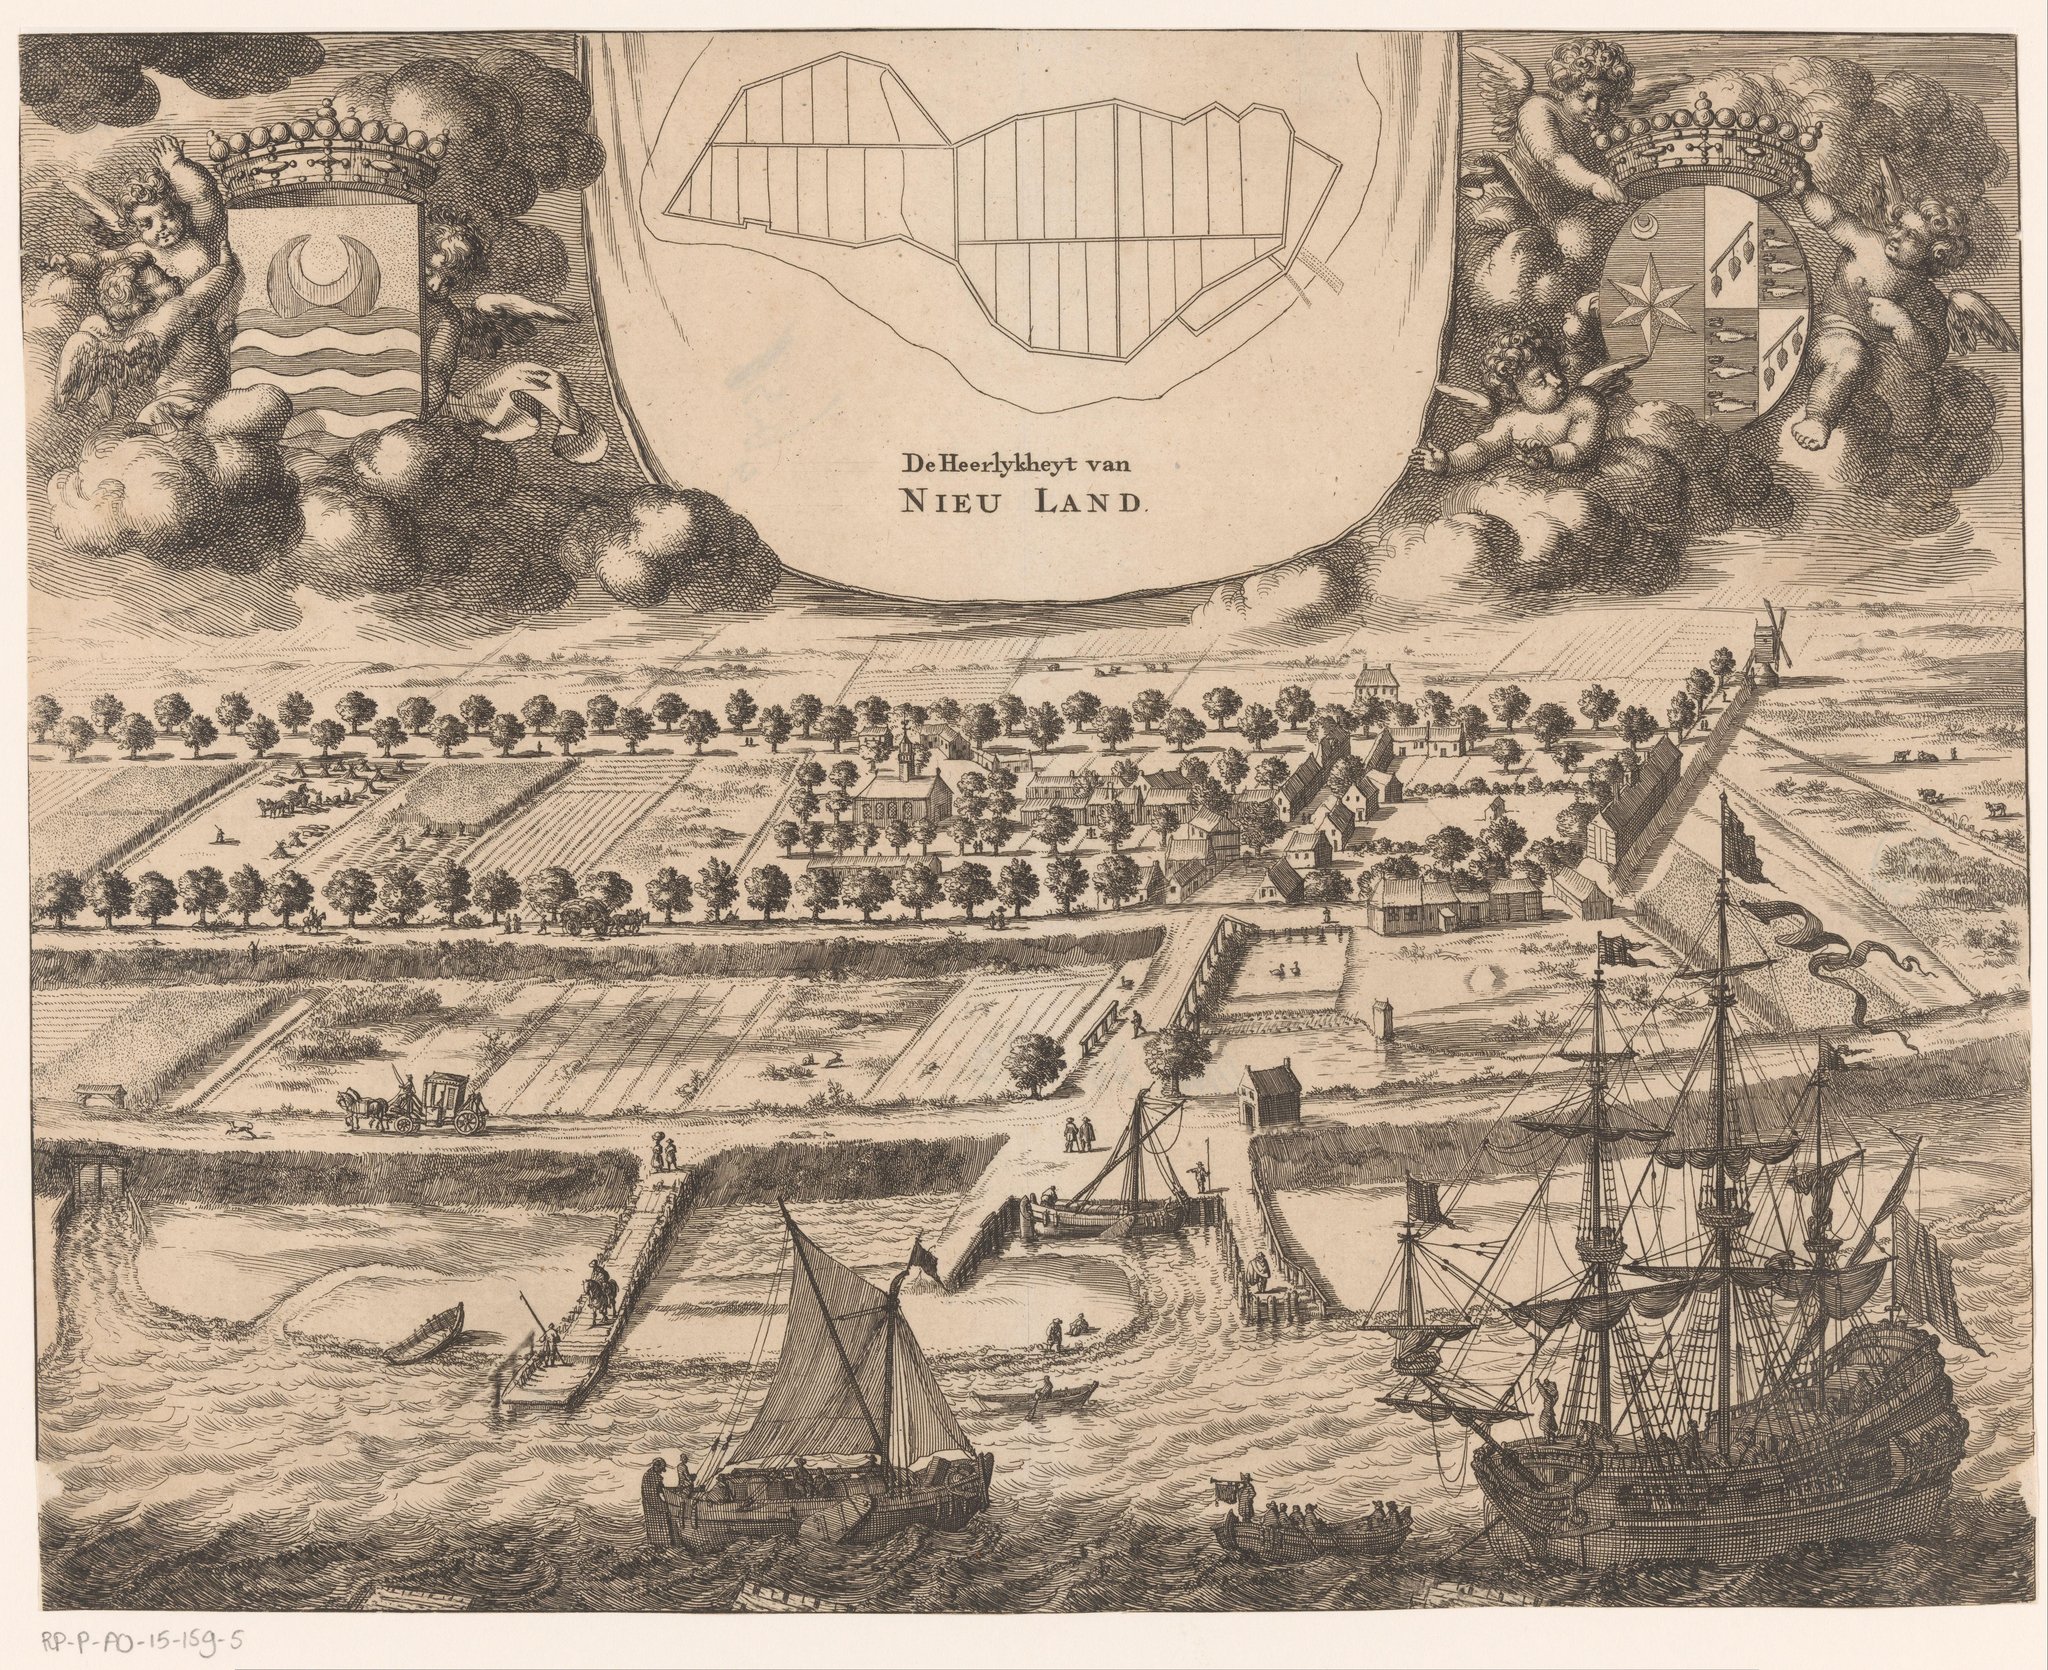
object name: book illustration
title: Gezicht op de heerlijkheid Nieuwland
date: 1696-1728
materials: paper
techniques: engraving, etching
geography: middelburg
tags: coat of arms (as symbol of the state, etc.), sailing-ship, sailing-boat, maps of separate countries or regions, church (exterior), polder, reclaimed land, armorial bearing, heraldry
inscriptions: collector's mark: Lugt 195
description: Doordat deze prent binnen de plaatrand is afgesneden kan de staat niet bepaald worden. Eerste bekende staat van prent (rechtsboven genummerd) ook gebruikt in: Smallegange, Mattheus. Nieuwe Cronyk van Zeeland (…). Middelburg en Amsterdam: Johannes Meertens en Abraham van Someren, 1696. Tweede bekende staat van prent (geen nummering rechtsboven) ook gebruikt in sommige exemplaren van: Aa, Pieter van der. La galerie agreable du monde (...). 66 delen. Leiden: Pieter van der Aa, 1728, dl. 21.